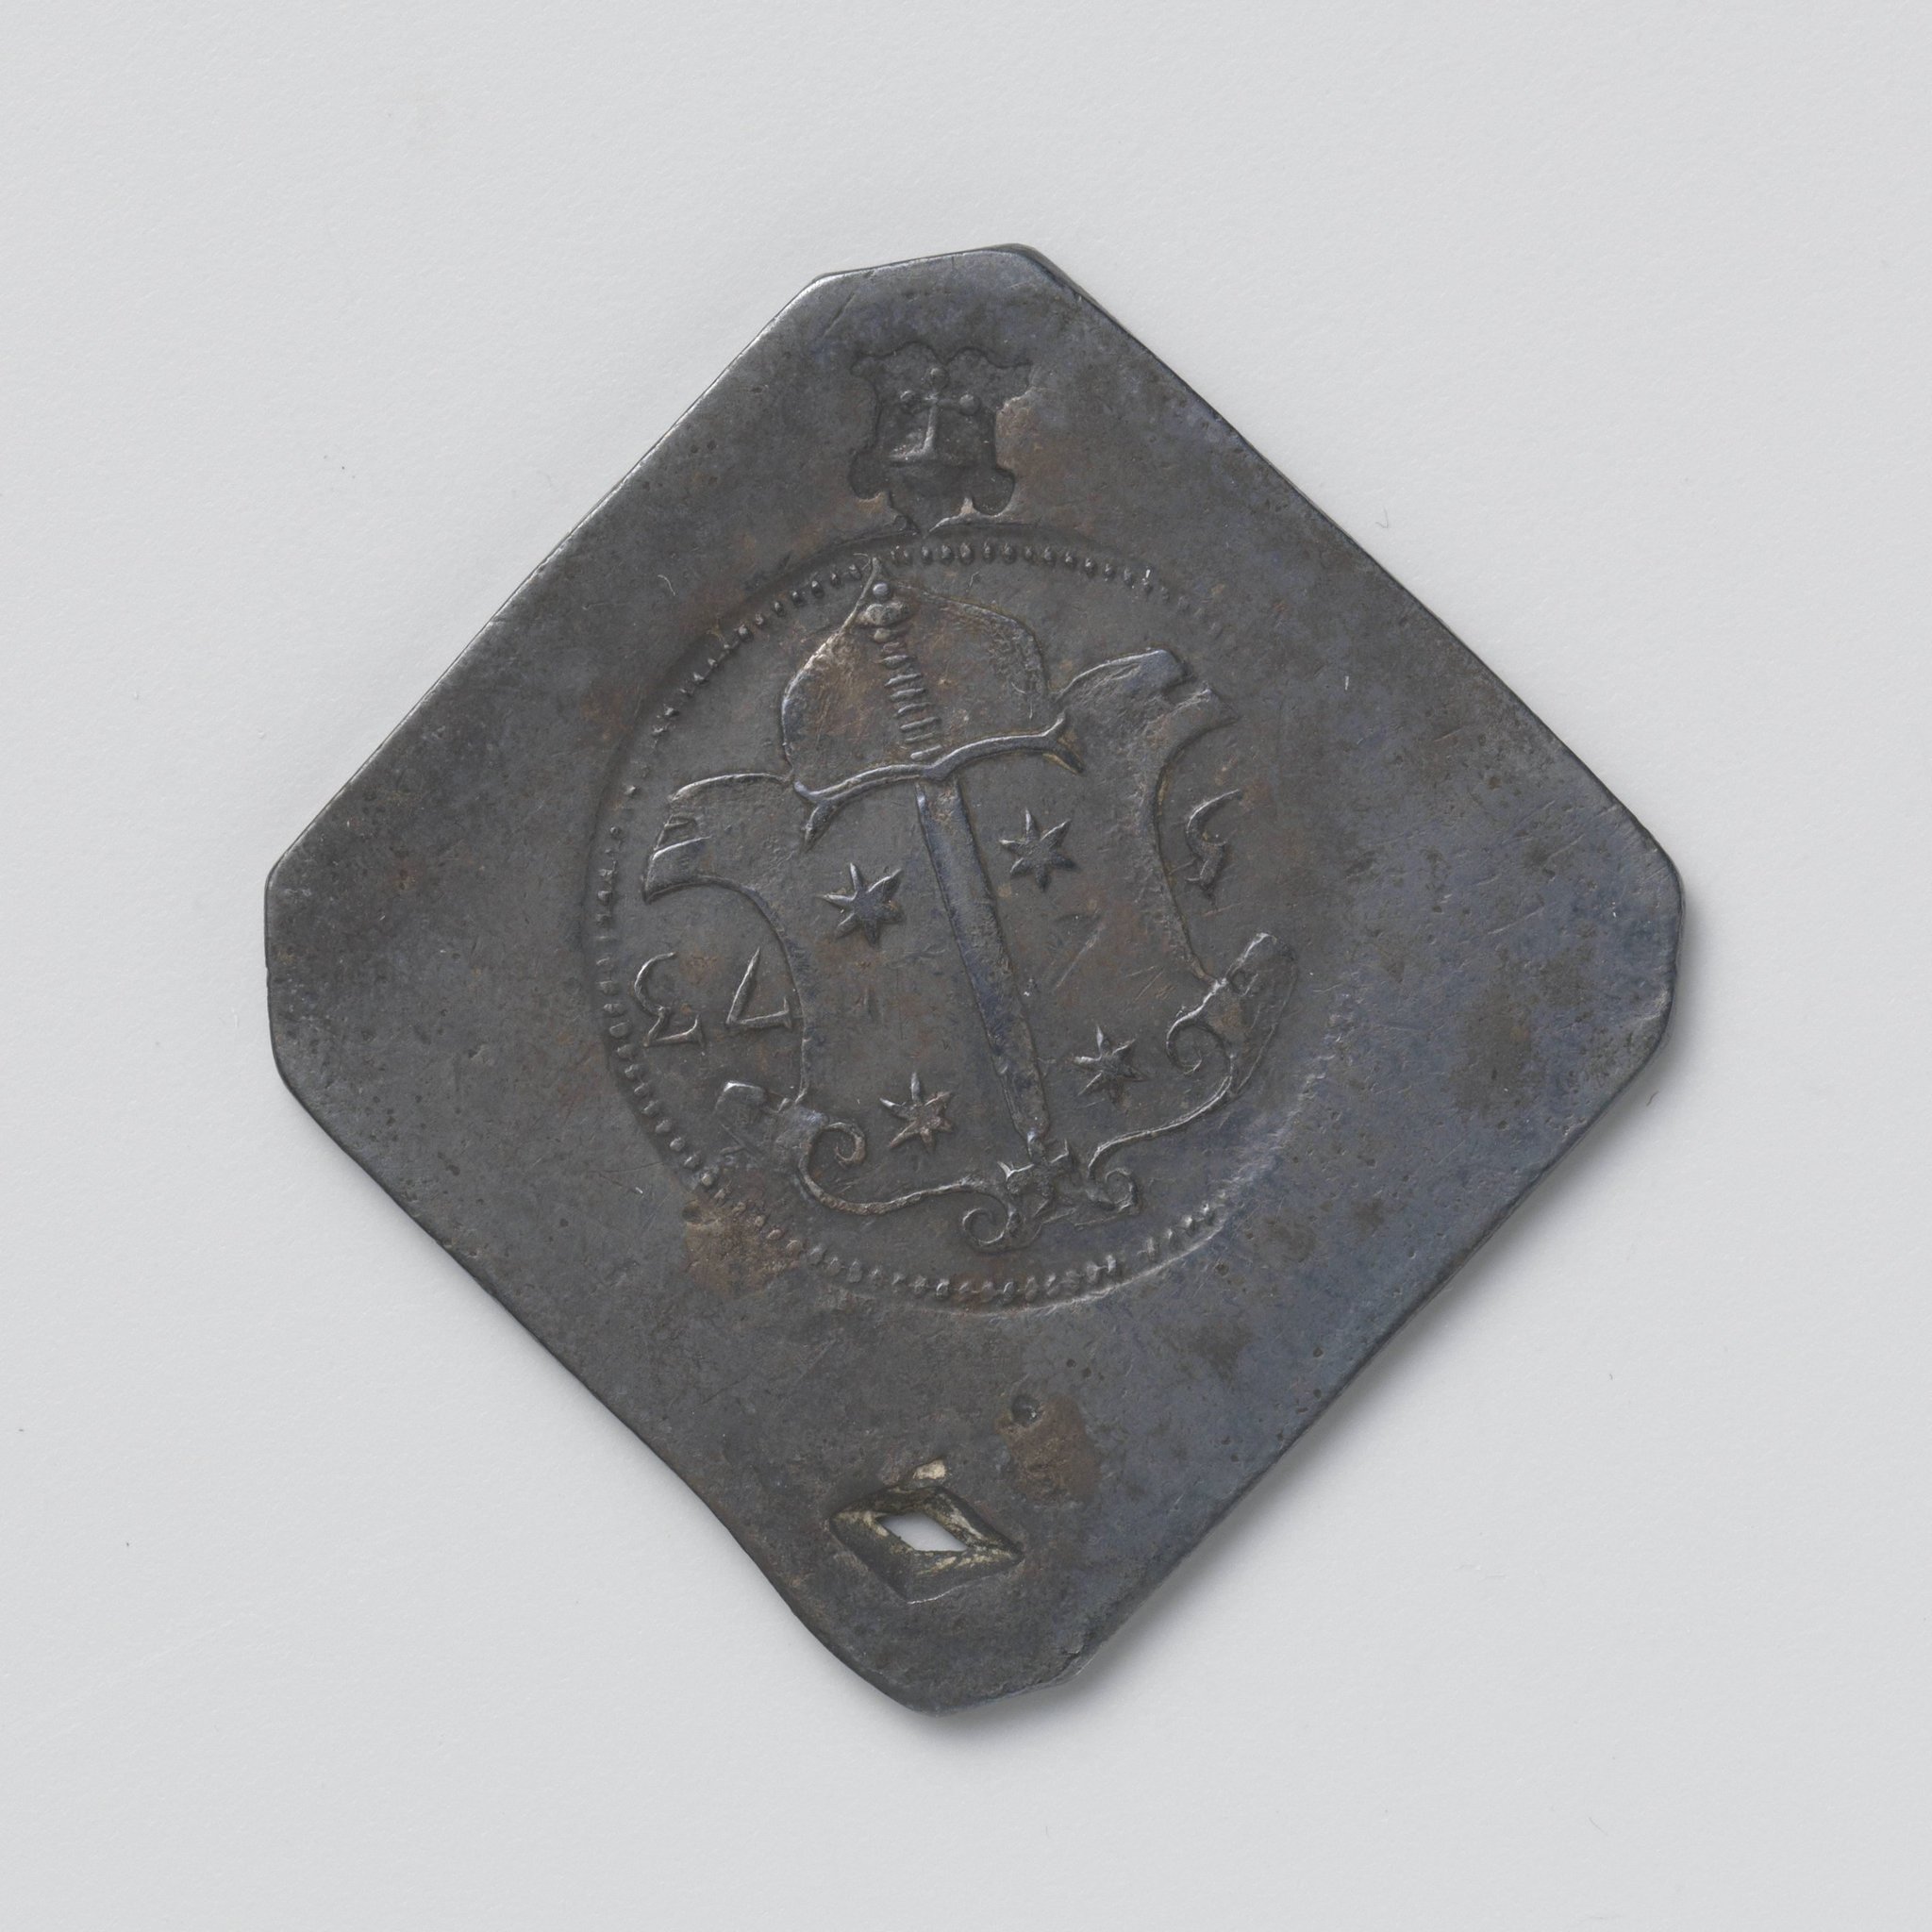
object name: coin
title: Gulden, noodmunt uit Haarlem, geslagen tijdens het beleg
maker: Anonymous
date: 1573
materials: silver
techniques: striking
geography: haarlem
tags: haarlem